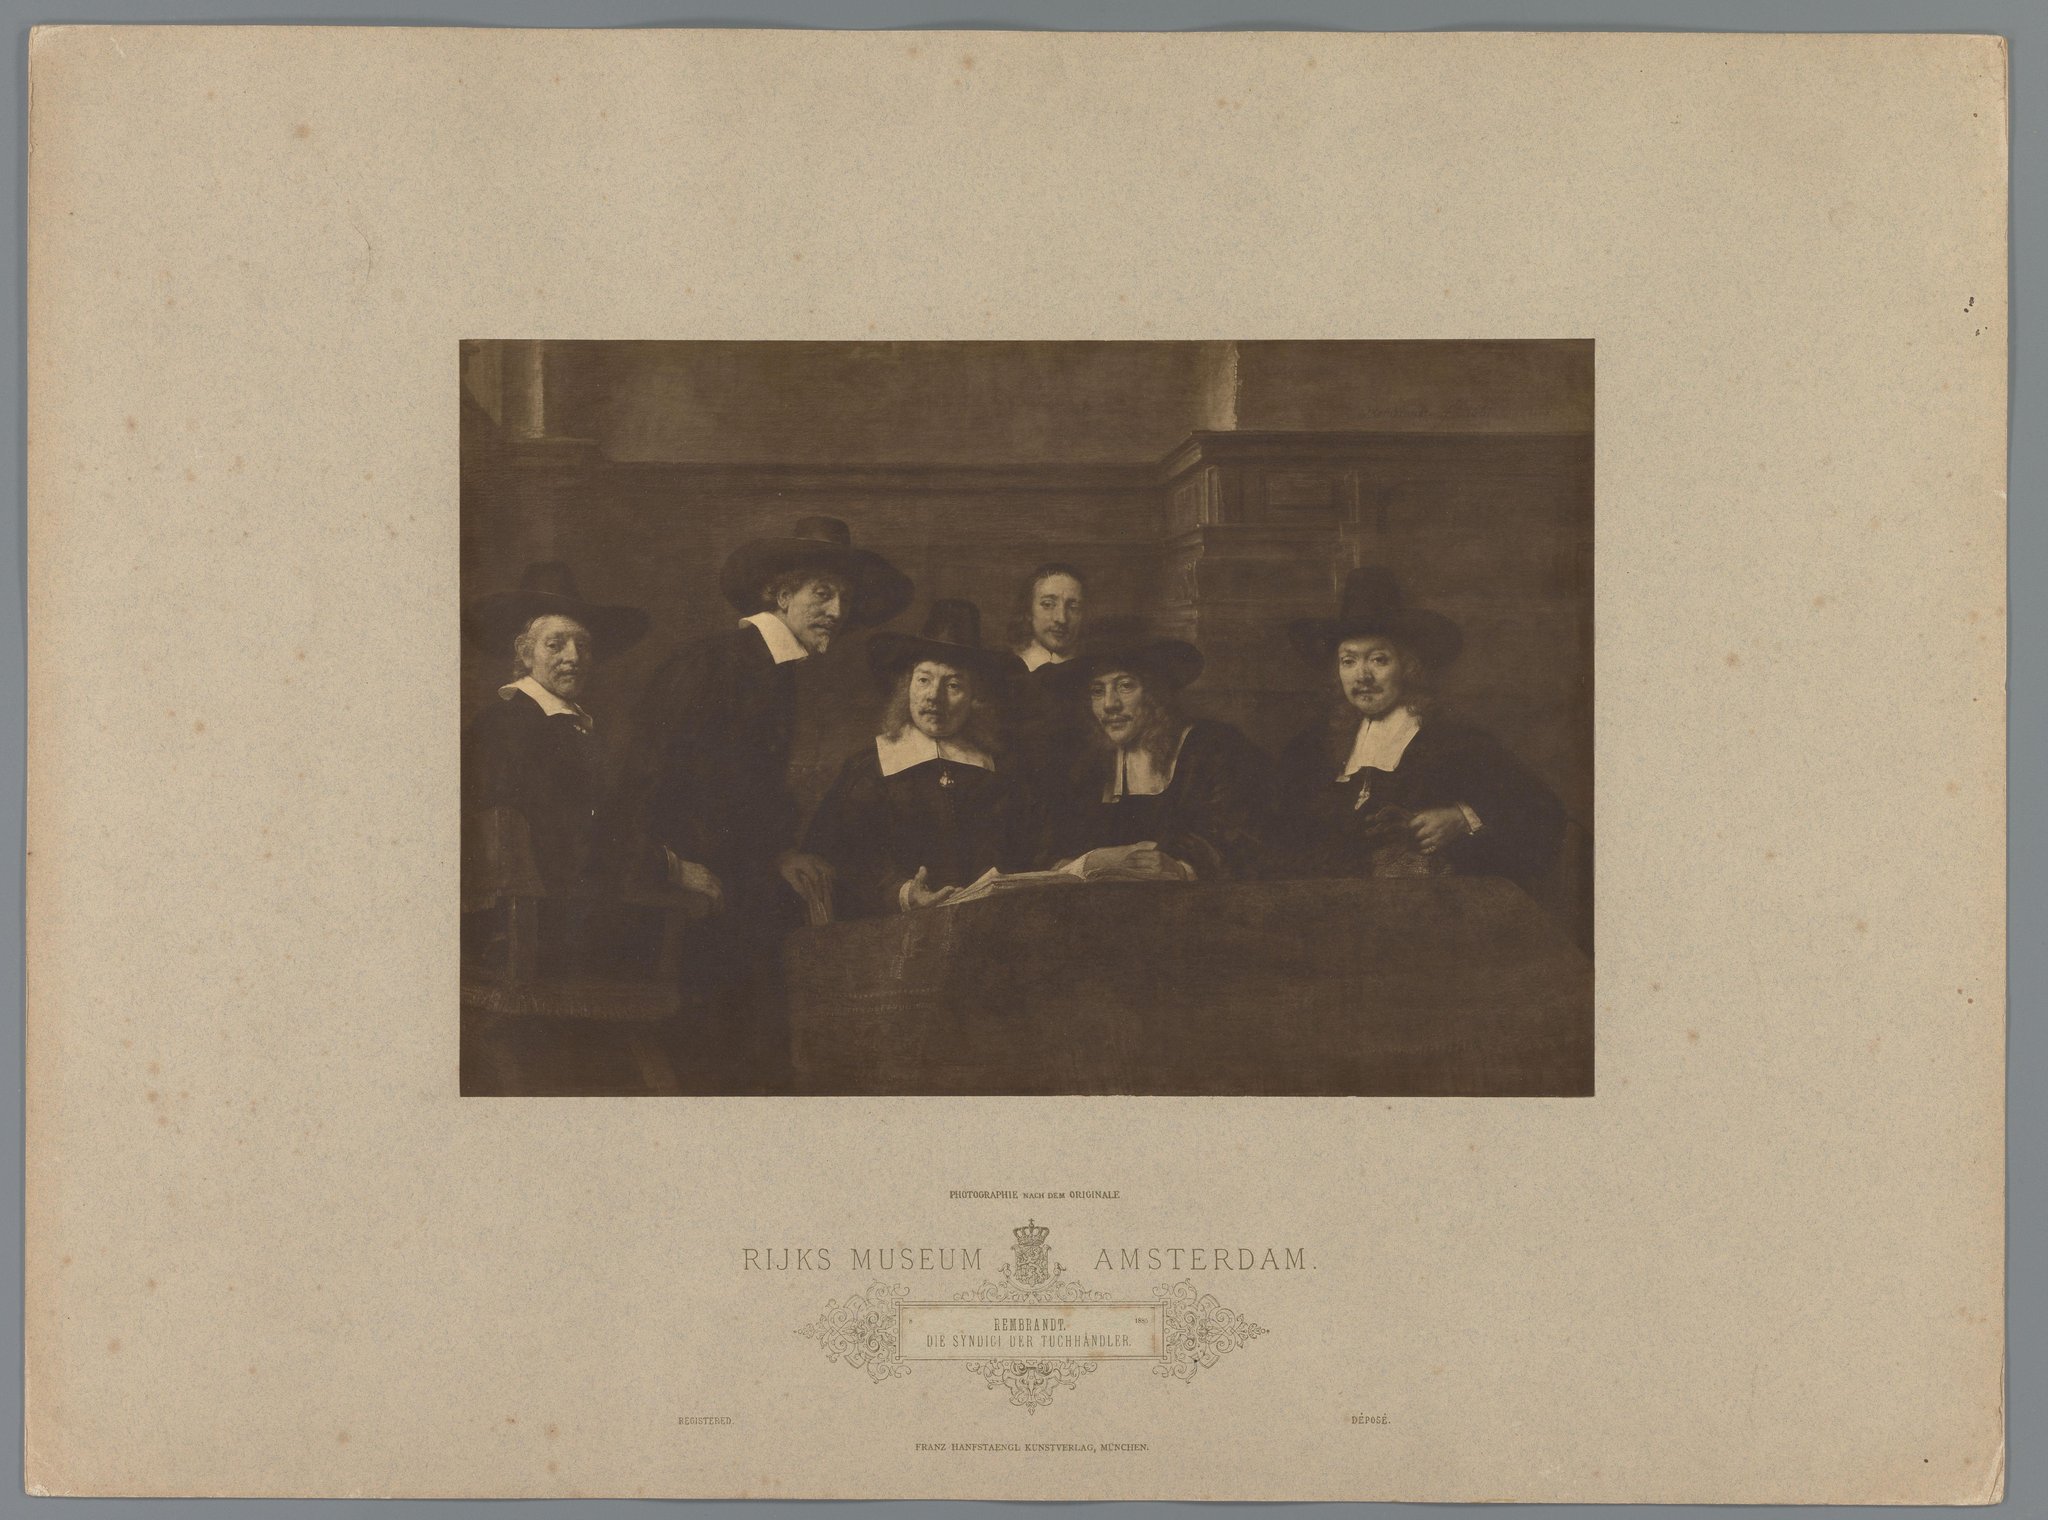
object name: photograph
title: Fotoreproductie van het schilderij De staalmeesters door Rembrandt van Rijn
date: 1885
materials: cardboard, paper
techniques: carbon print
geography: munich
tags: officers trusted with control of quality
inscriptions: number: ‘8’, inscription: ‘Photographie nach dem Originale/ Rijks Museum Amsterdam/ Registered. Déposé.’